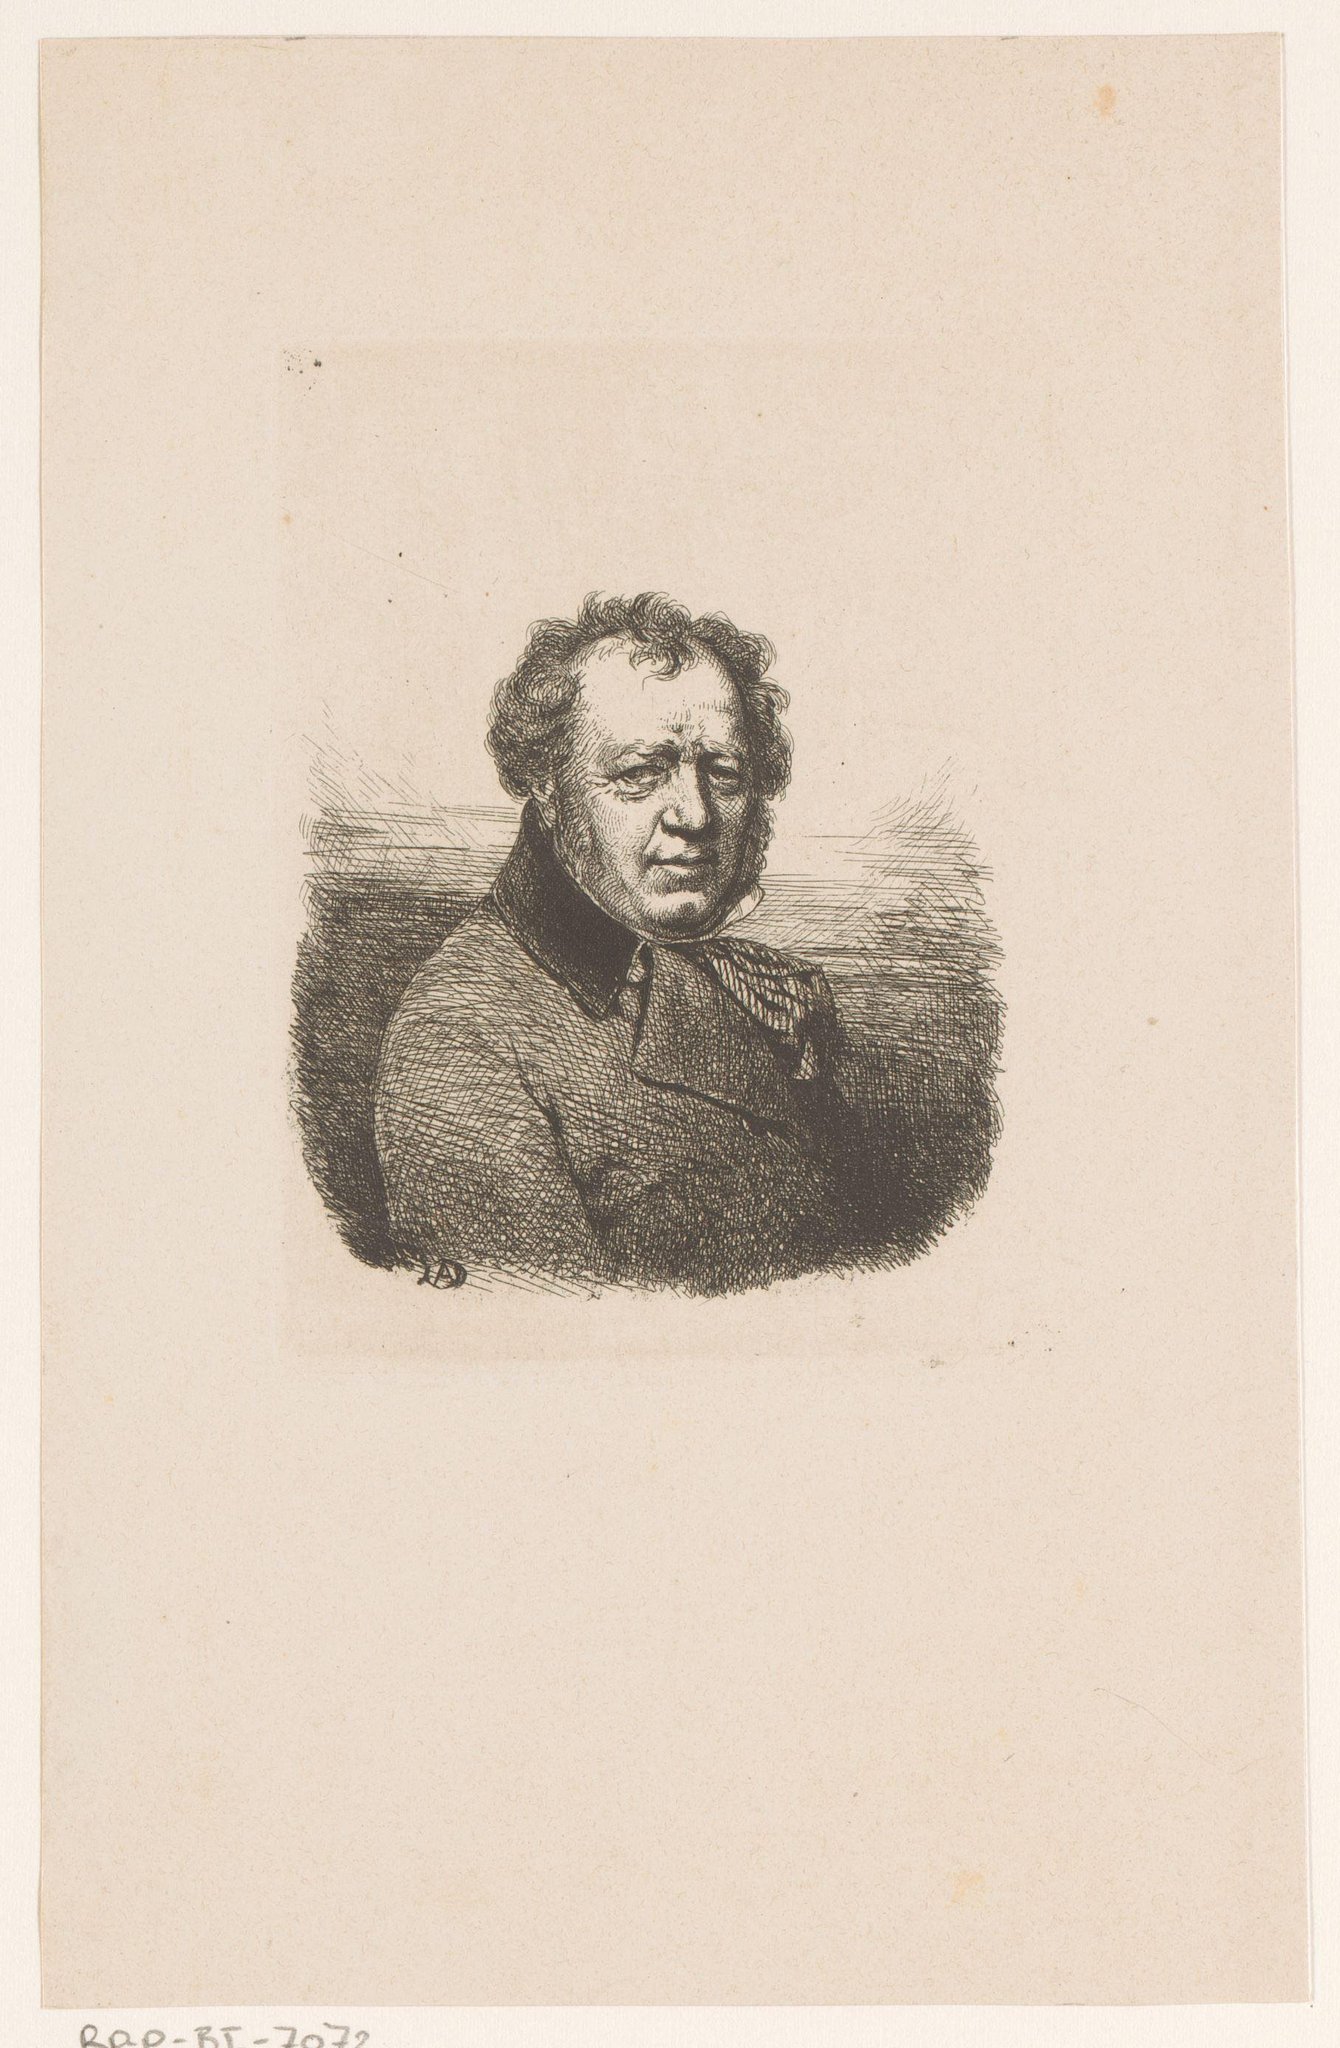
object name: print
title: Portret van Pierre Joseph Versturme-Roegiers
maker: adolphe alexandre dillens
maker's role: draughtsman, painter, print maker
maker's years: 1821-1877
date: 1831-1877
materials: paper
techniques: etching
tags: adult man, historical persons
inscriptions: collector's mark: Lugt 2228